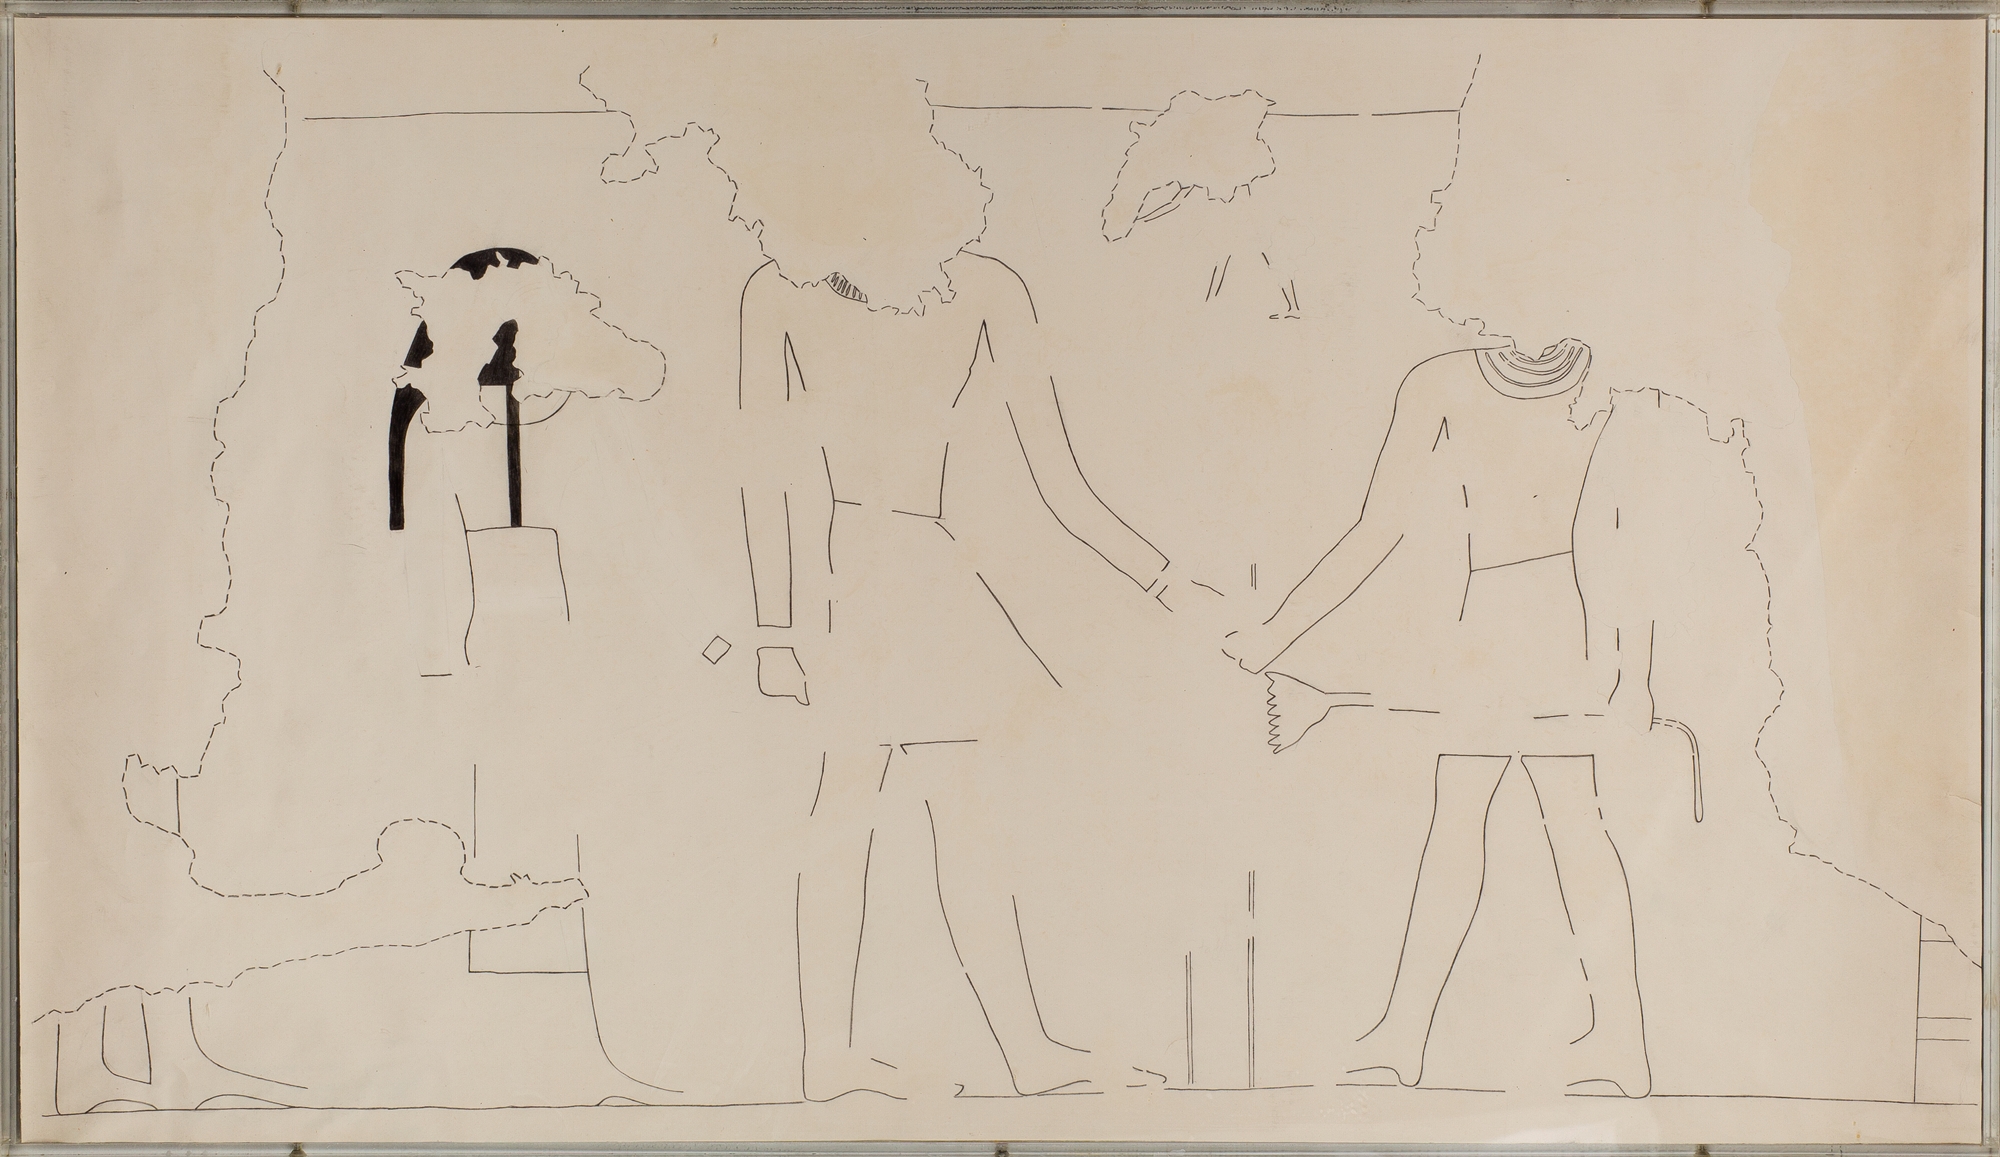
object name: facsimile, djari tt 366, offering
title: Offering Scene, Tomb of Djari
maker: unknown copyist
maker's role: artist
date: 2050-2000 BCE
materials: ink, paper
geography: egypt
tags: human figures